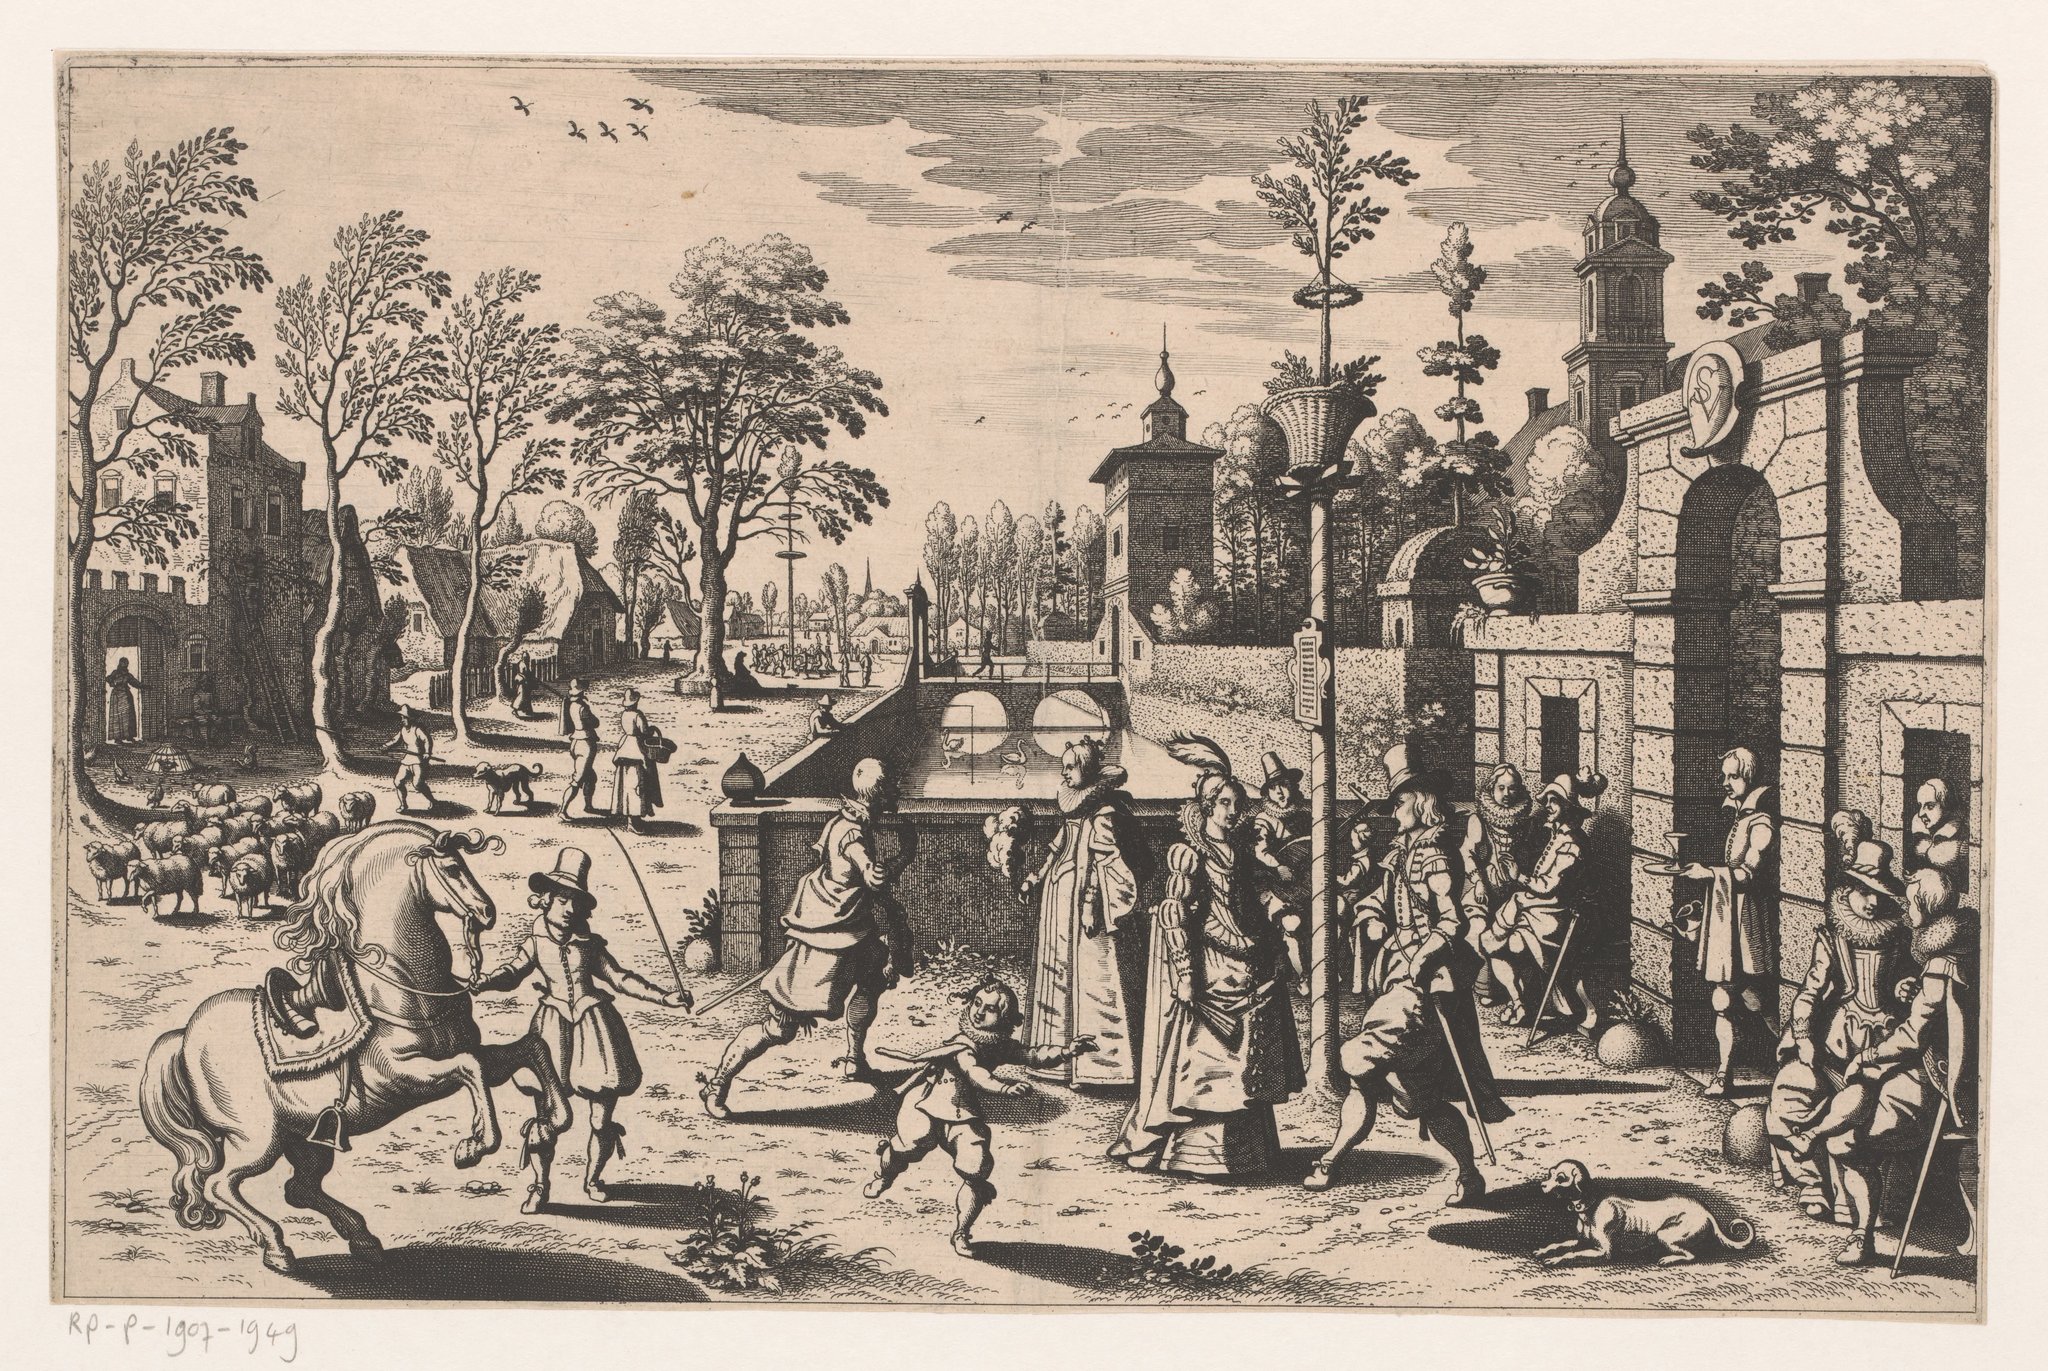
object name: print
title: Vier seizoenen naar Sebastiaan Vrancx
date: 1622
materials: paper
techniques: etching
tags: dancing around the maypole, spring landscape; landscape symbolizing spring (the four seasons of the year) (+ with scenes showing human occupations ~ seasons and months)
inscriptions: collector's mark: Lugt 2228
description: Deze prent mist de tekst aan de onderkant.